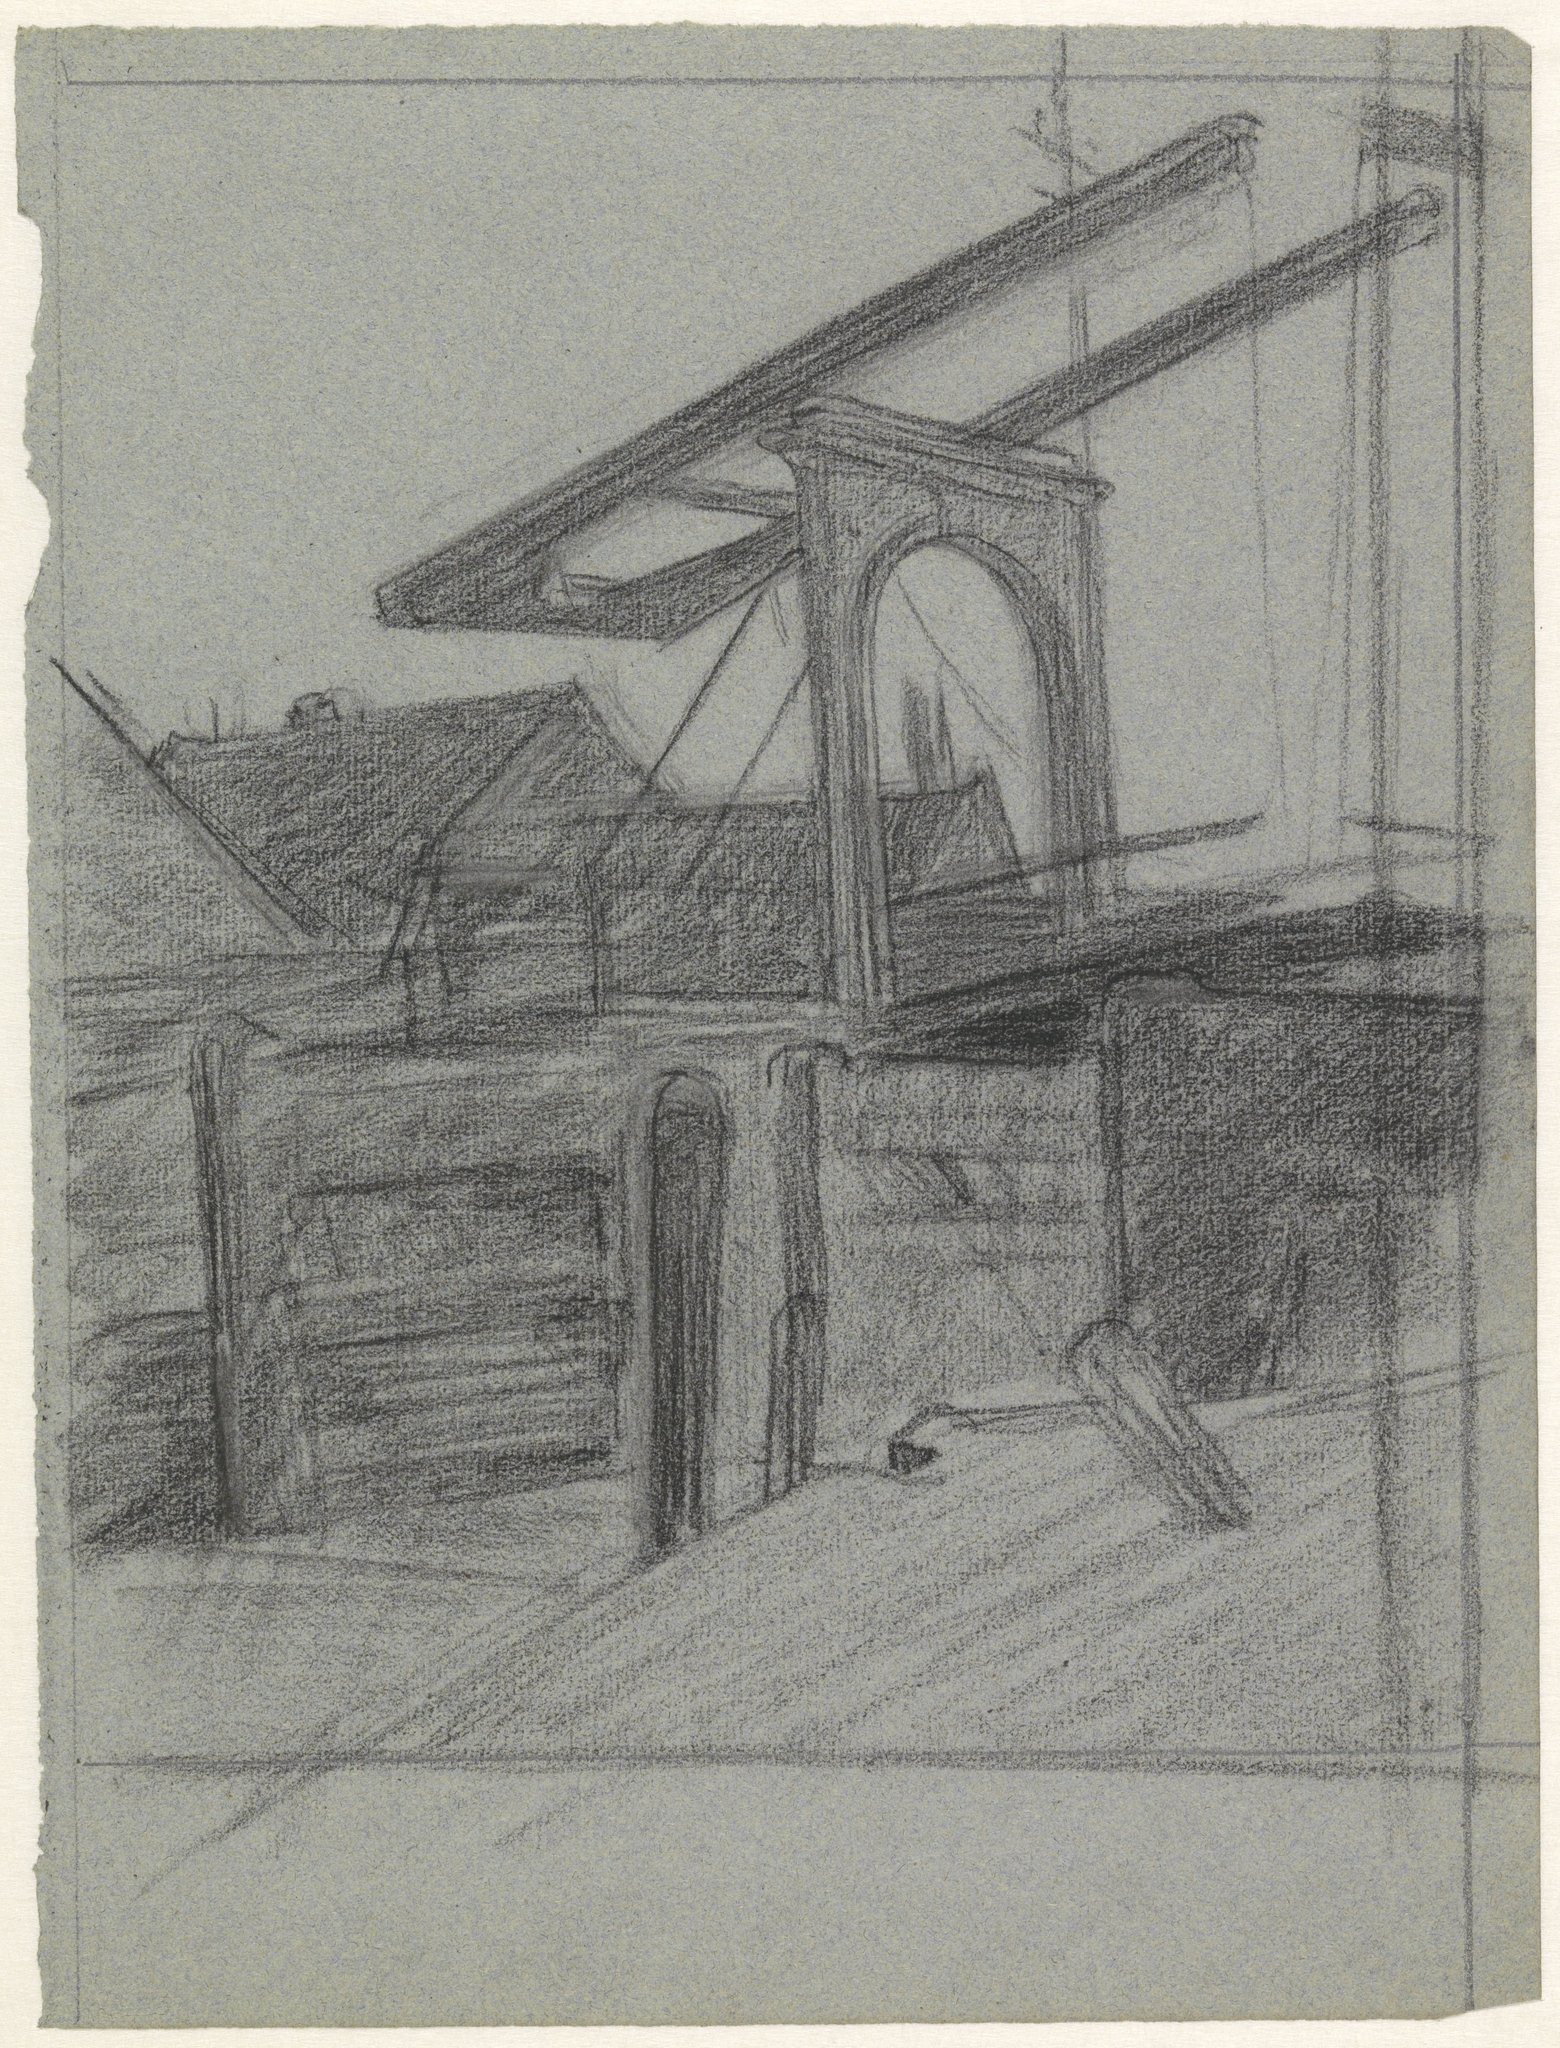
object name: drawing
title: Ophaalbrug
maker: jan veth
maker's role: designer, draughtsman, painter, print maker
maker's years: 1864-1925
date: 1886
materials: chalk, paper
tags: bridge